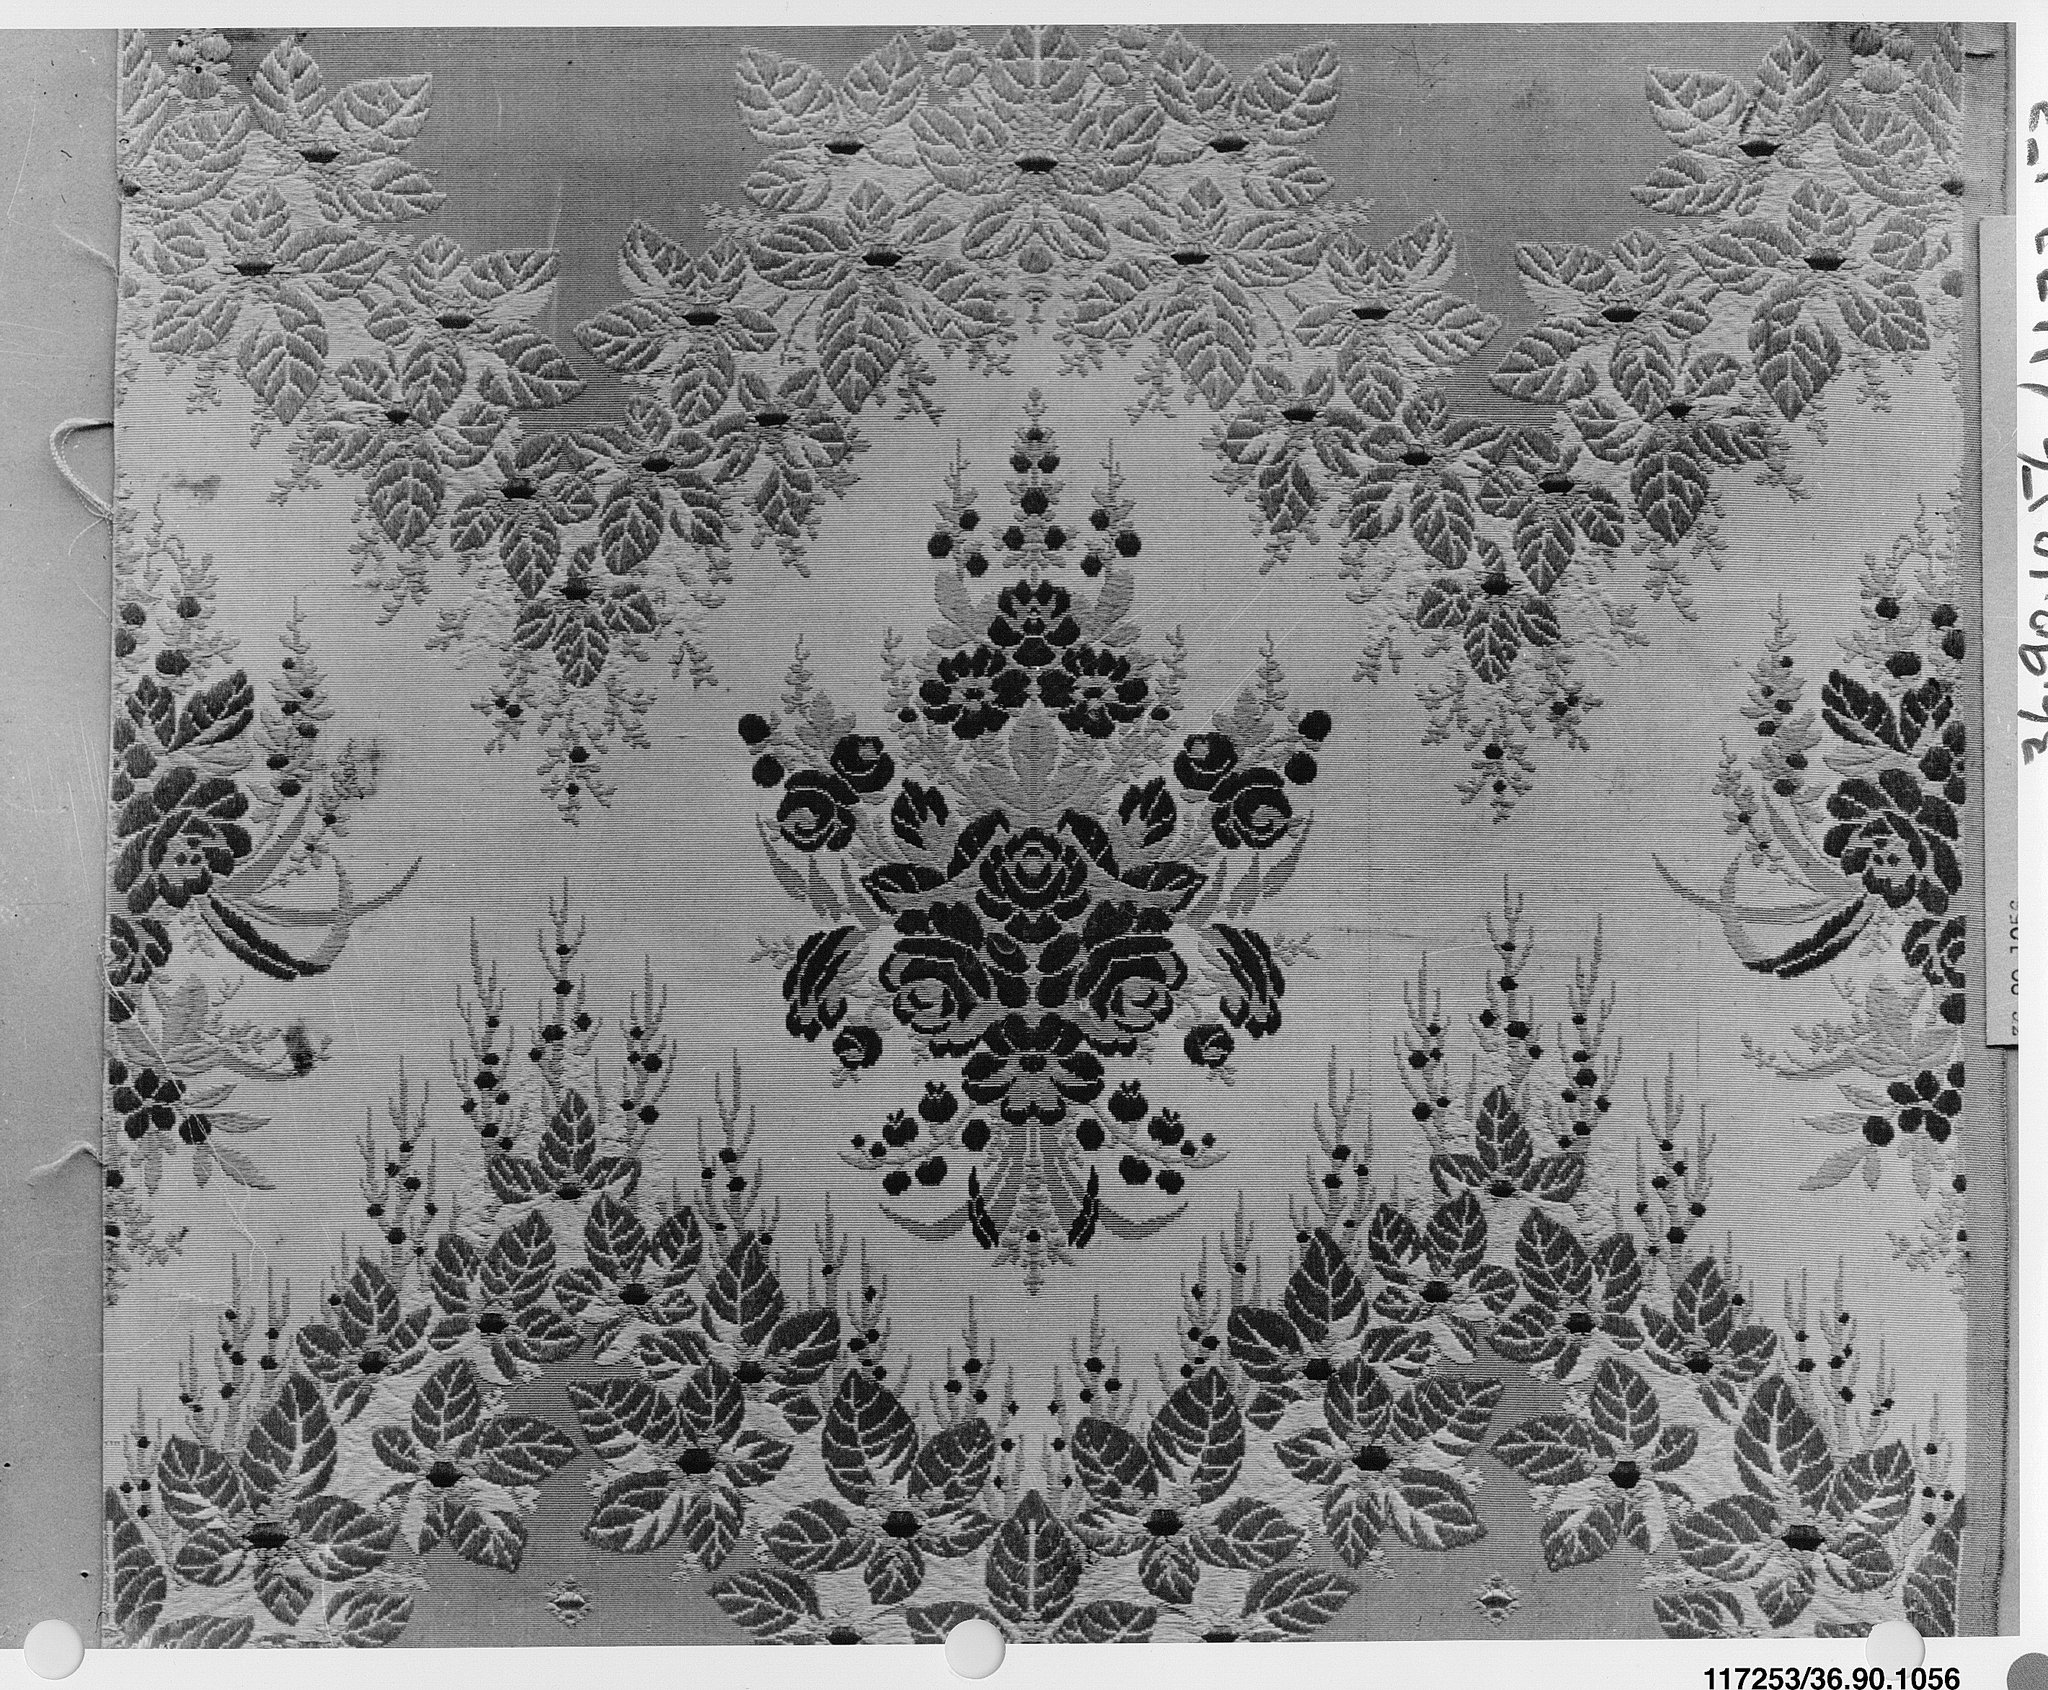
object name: piece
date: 1801-1900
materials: silk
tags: flowers,leaves